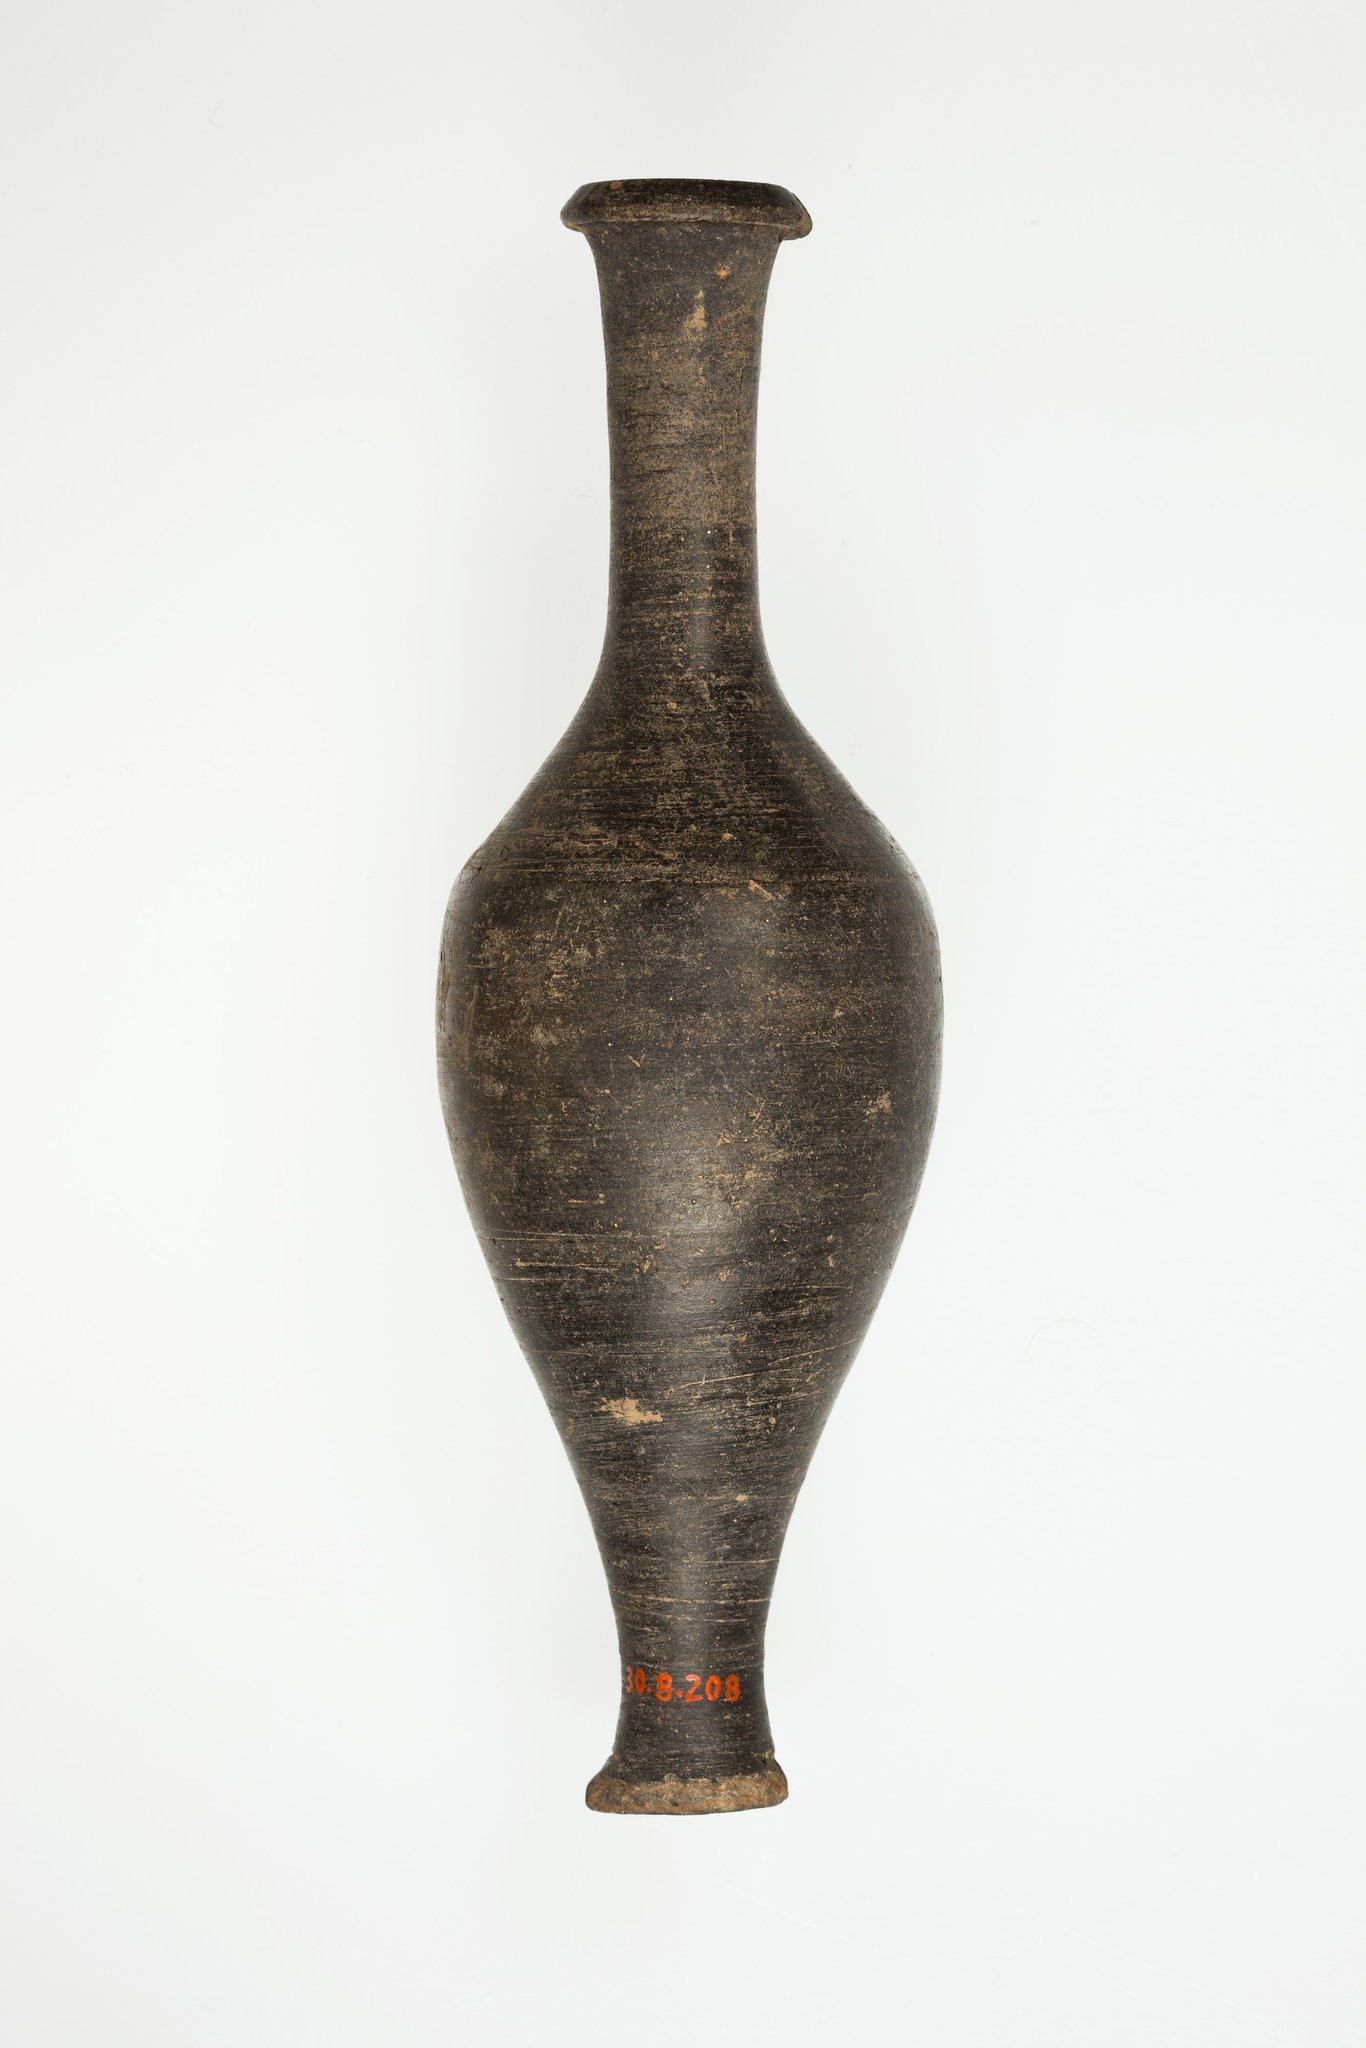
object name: bottle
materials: pottery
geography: egypt